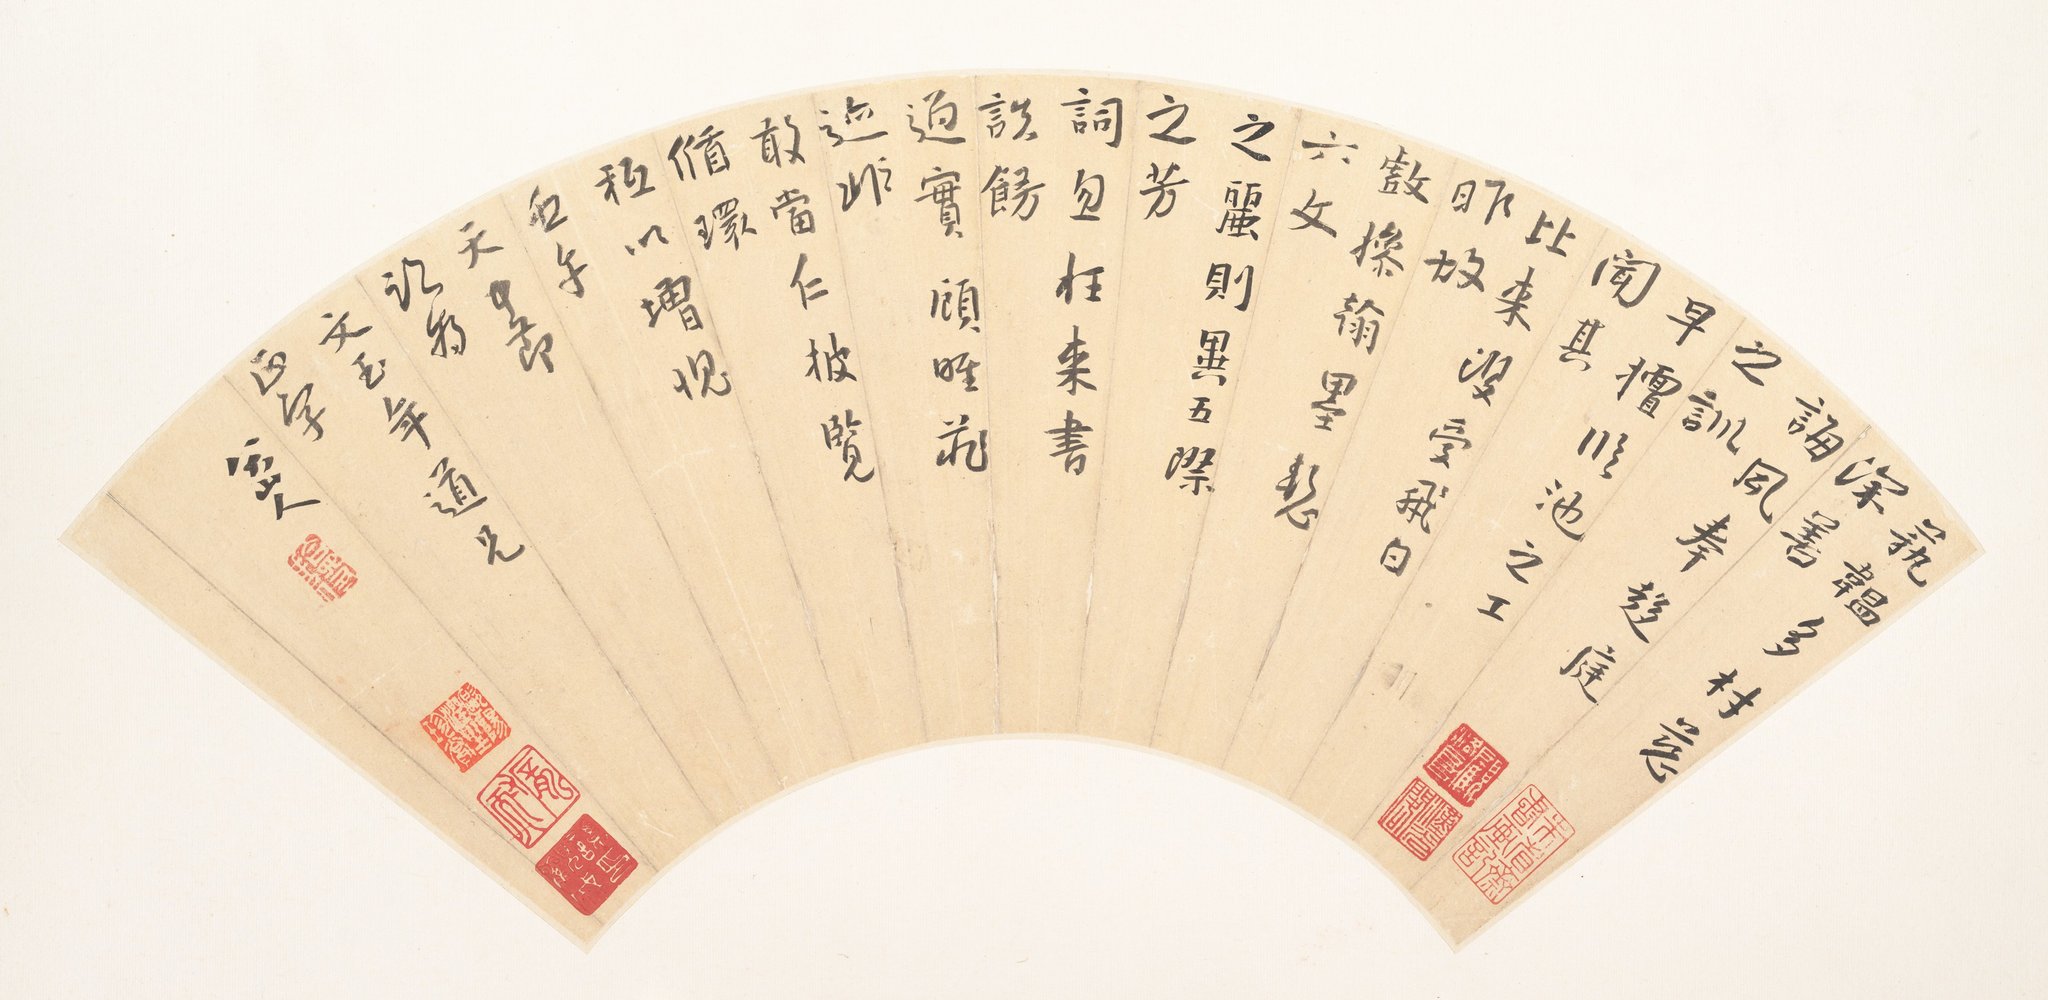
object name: folding fan mounted a an album leaf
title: Letter by Li Zhi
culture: chinese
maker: bada shanren (zhu da)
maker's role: artist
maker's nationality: chinese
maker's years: 1626-1705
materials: ink, paper